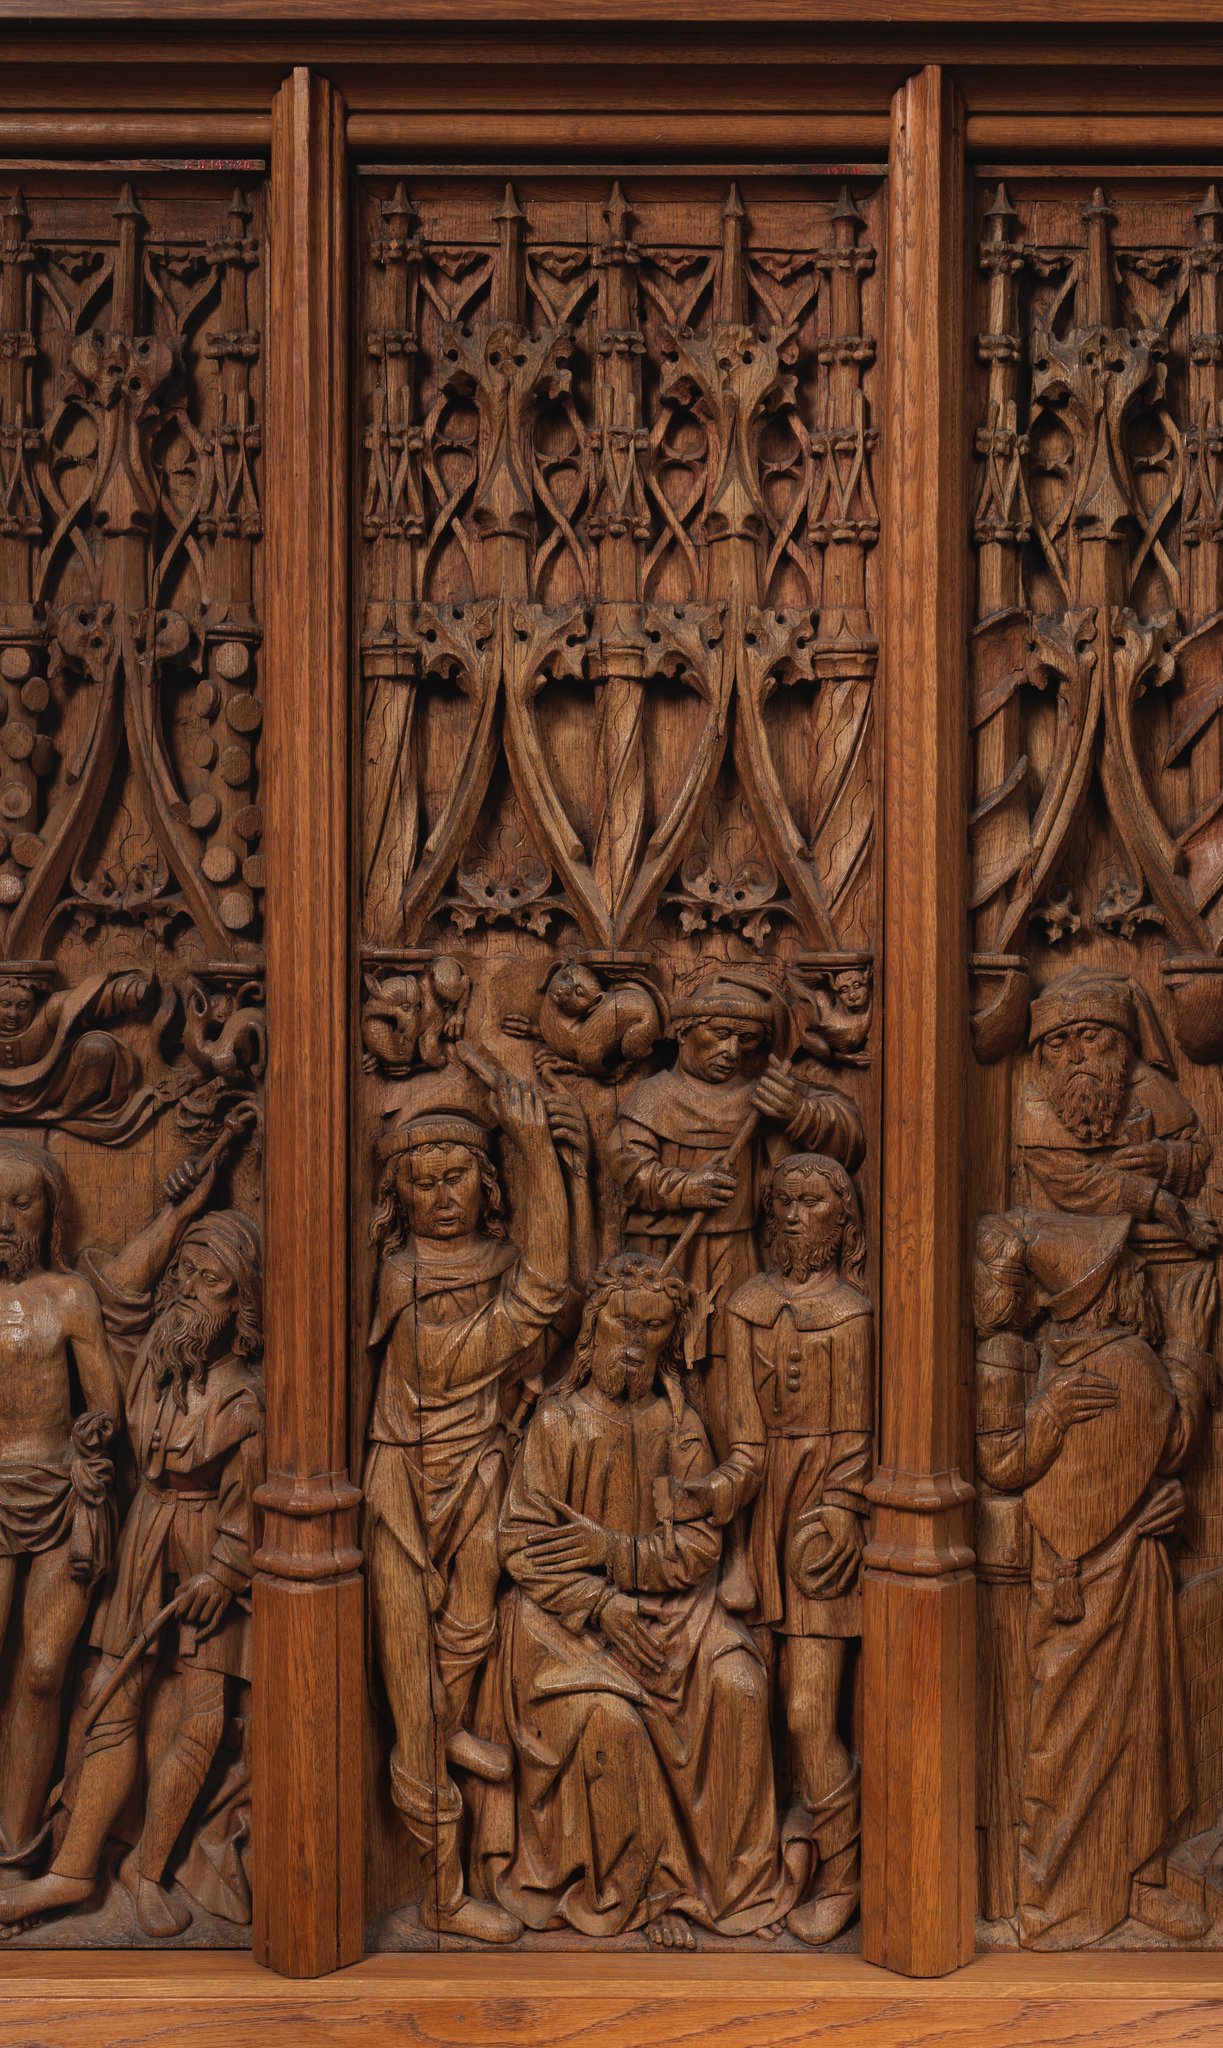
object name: panel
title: Panel with Christ Crowned with Thorns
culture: french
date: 1501-1533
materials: wood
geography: france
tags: cross